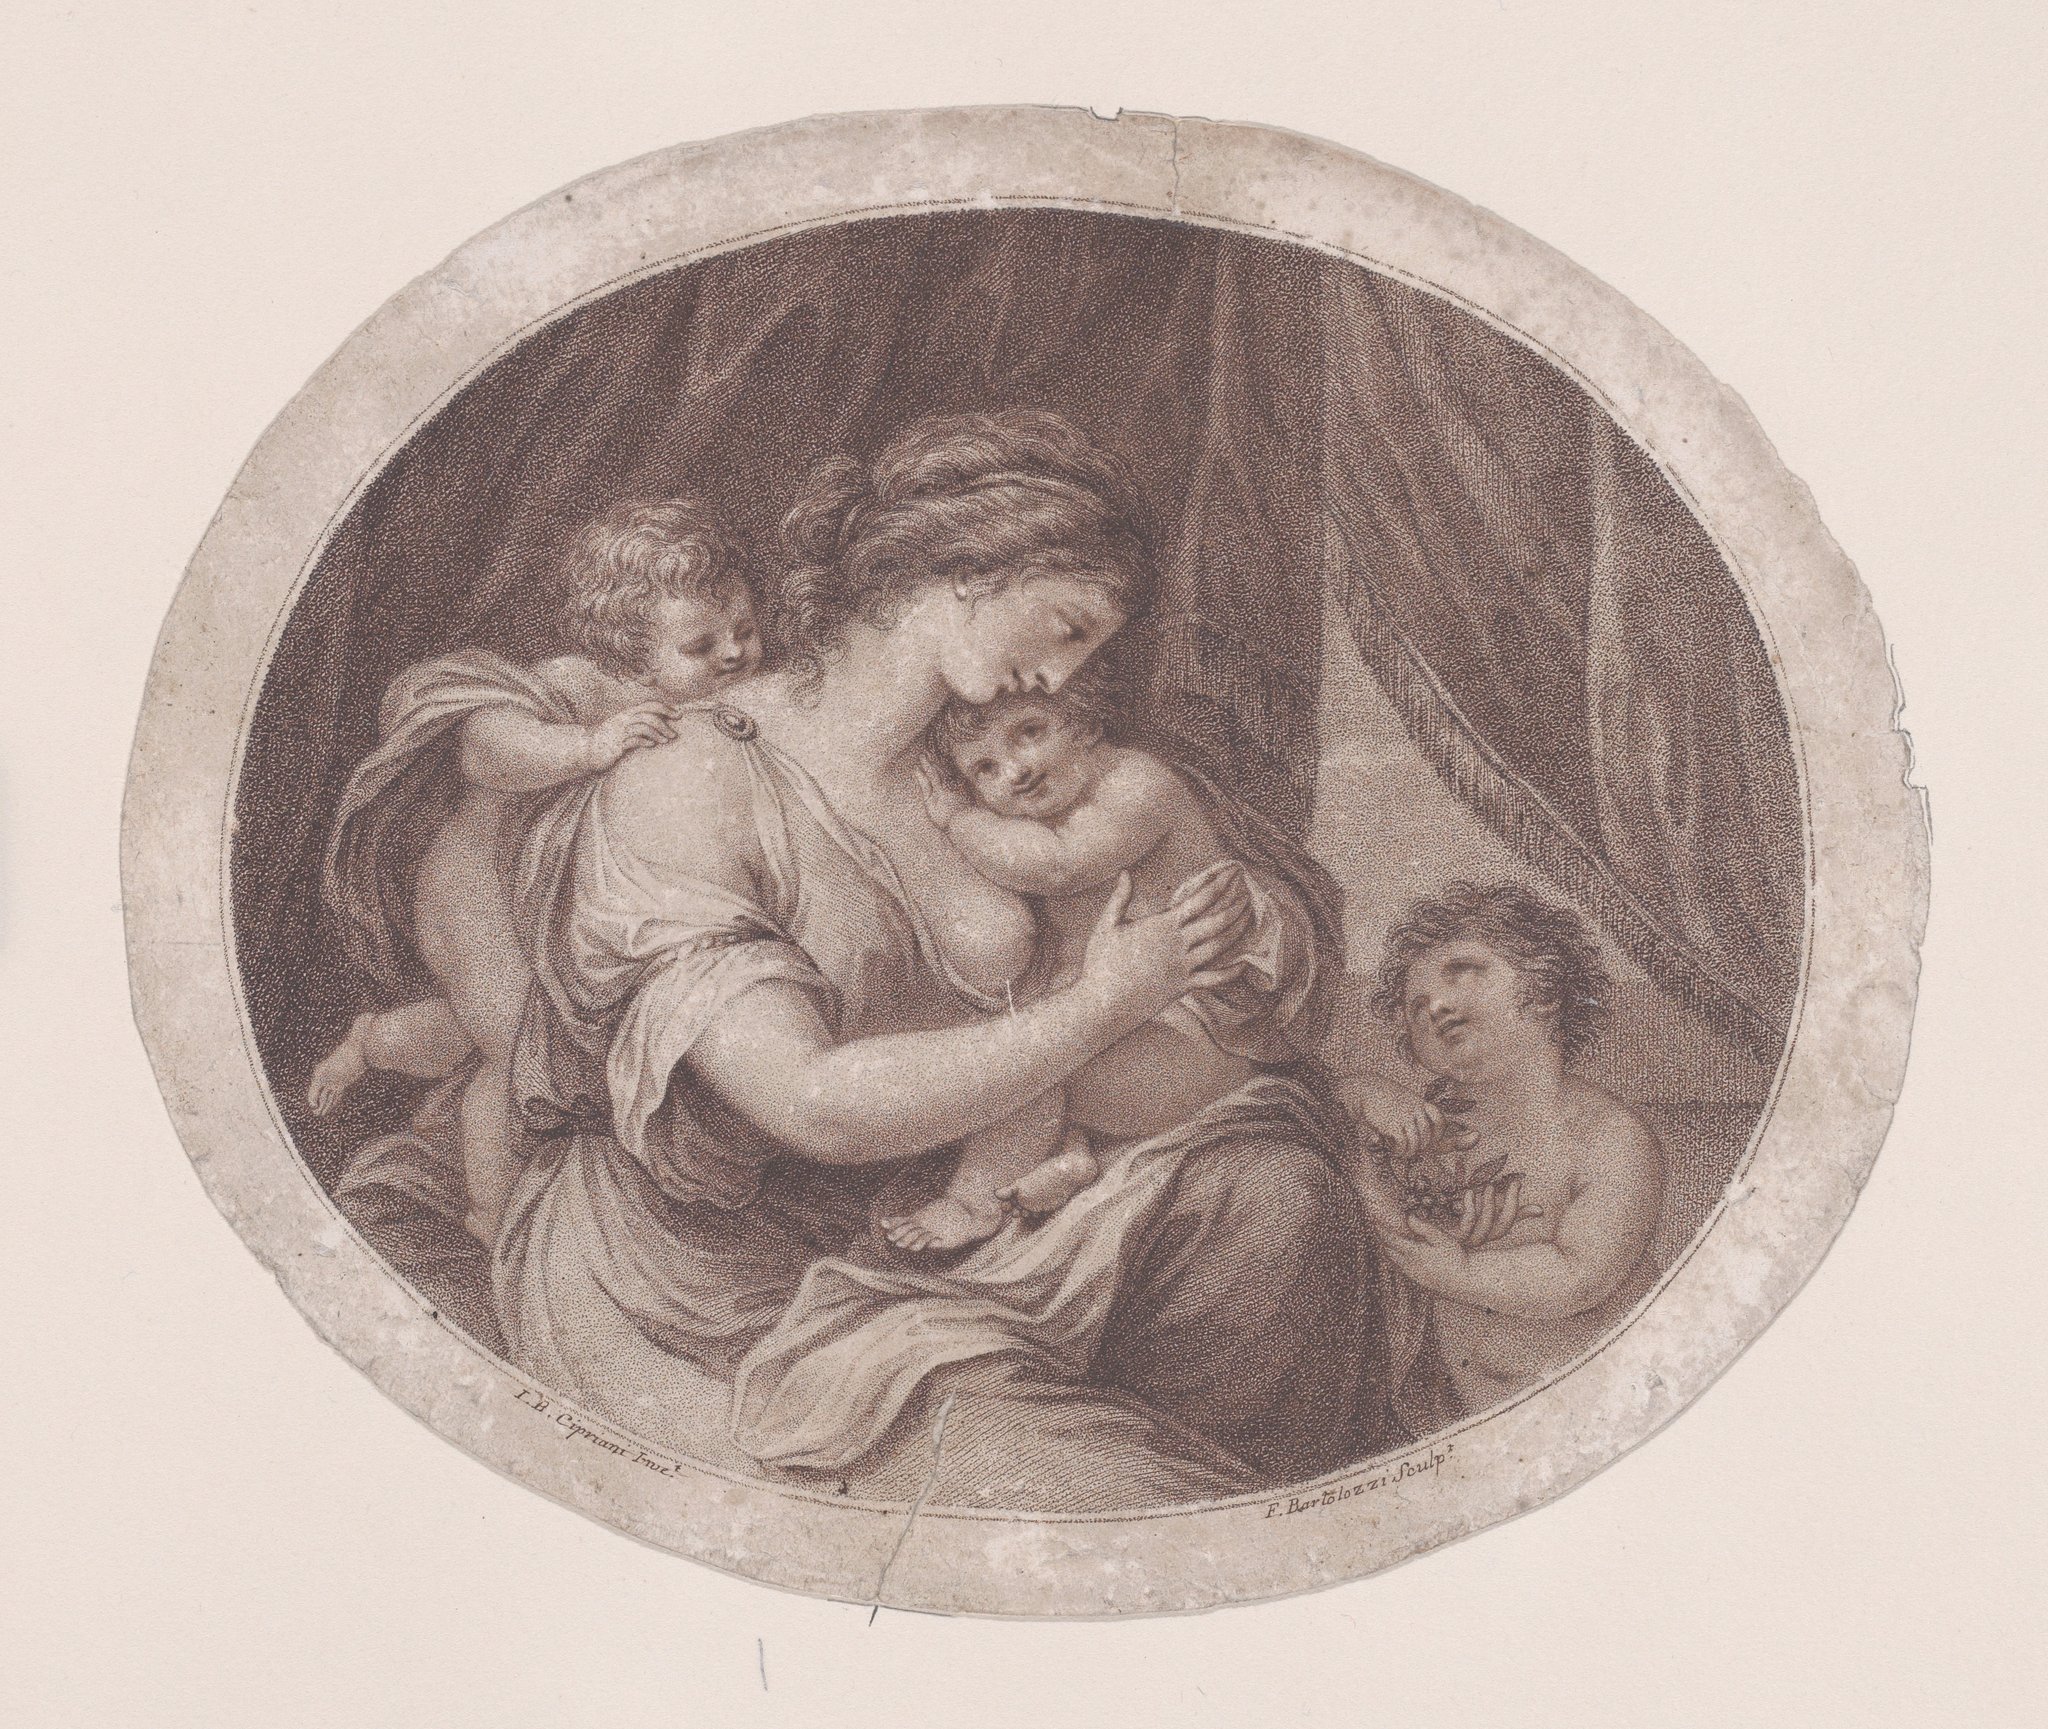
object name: print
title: Maternal Love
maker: francesco bartolozzi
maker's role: artist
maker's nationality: italian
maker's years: 1728-1815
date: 1784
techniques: etching, engraving